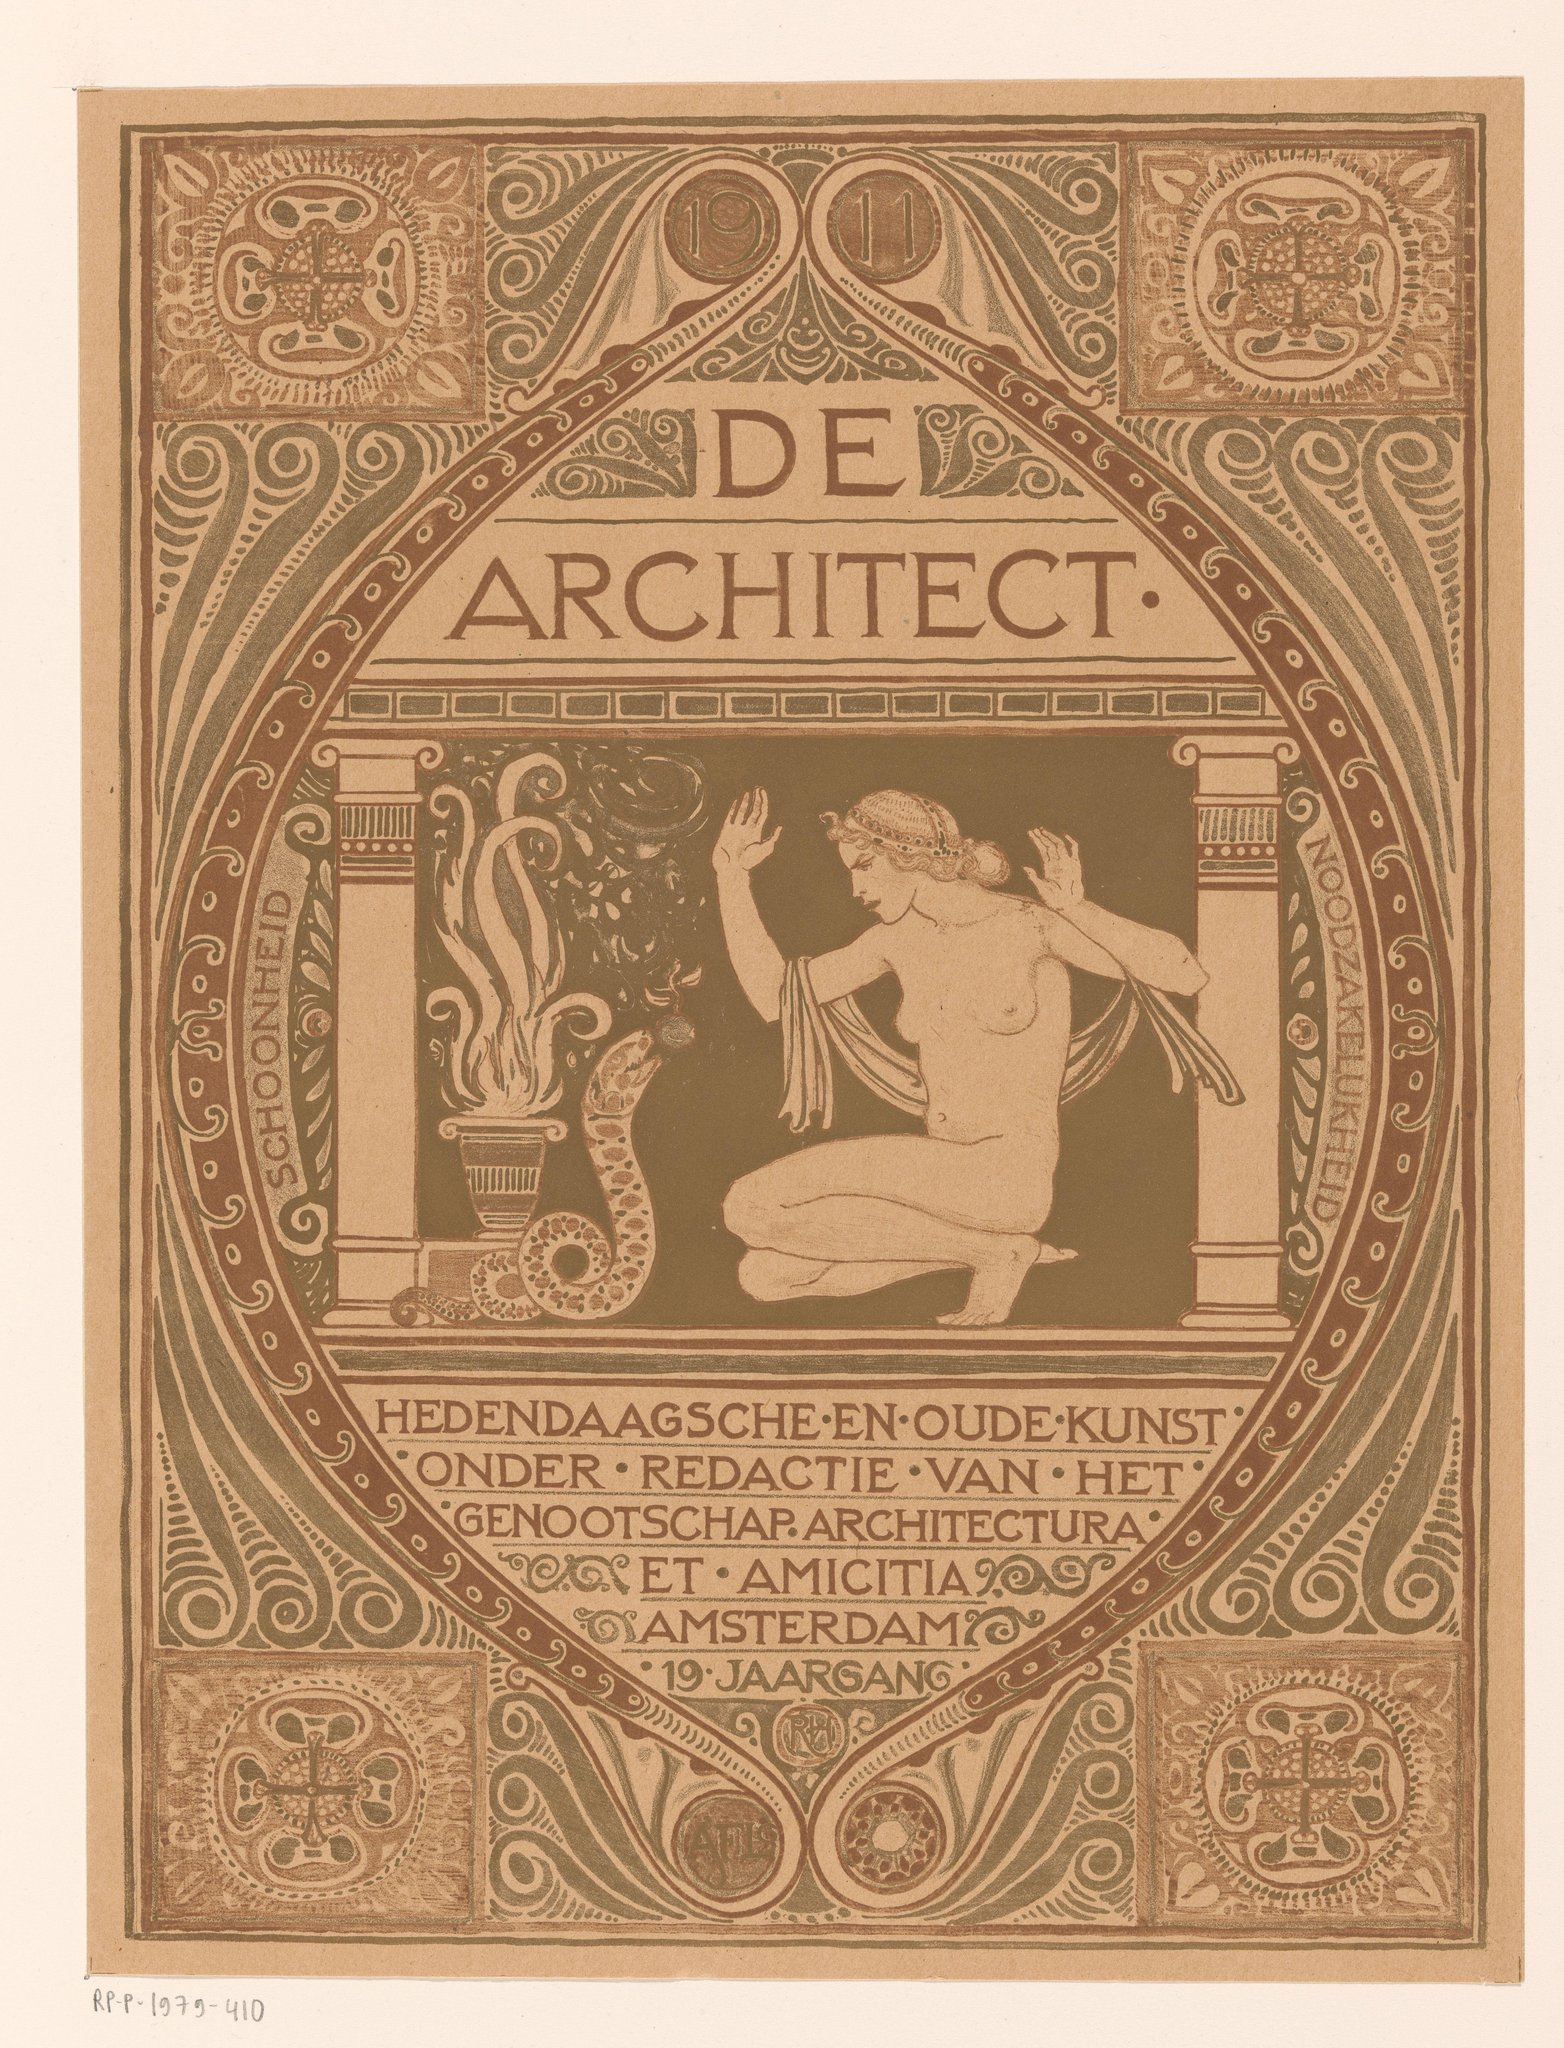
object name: print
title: Omslagontwerp voor: De Architect, 1911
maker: richard nicolaüs roland holst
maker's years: 1868-1938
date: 1911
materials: paper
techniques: lithograph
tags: snakes, kneeling figure - aa - female human figure, column, pillar ~ architecture, open fire (in general), woman (showing herself) undressed, quasi-nude, fruits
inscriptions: collector's mark: Lugt 2228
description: Een rechthoekig kader met daarin een naakte vrouw die knielt bij een slang die een vrucht in zijn bek heeft. De vrouw houdt haar armen in de lucht. Op de achtergrond twee zuilen en een vuur. Links het woord 'SCHOONHEID', rechts het woord 'NOODZAKELIJKHEID'.